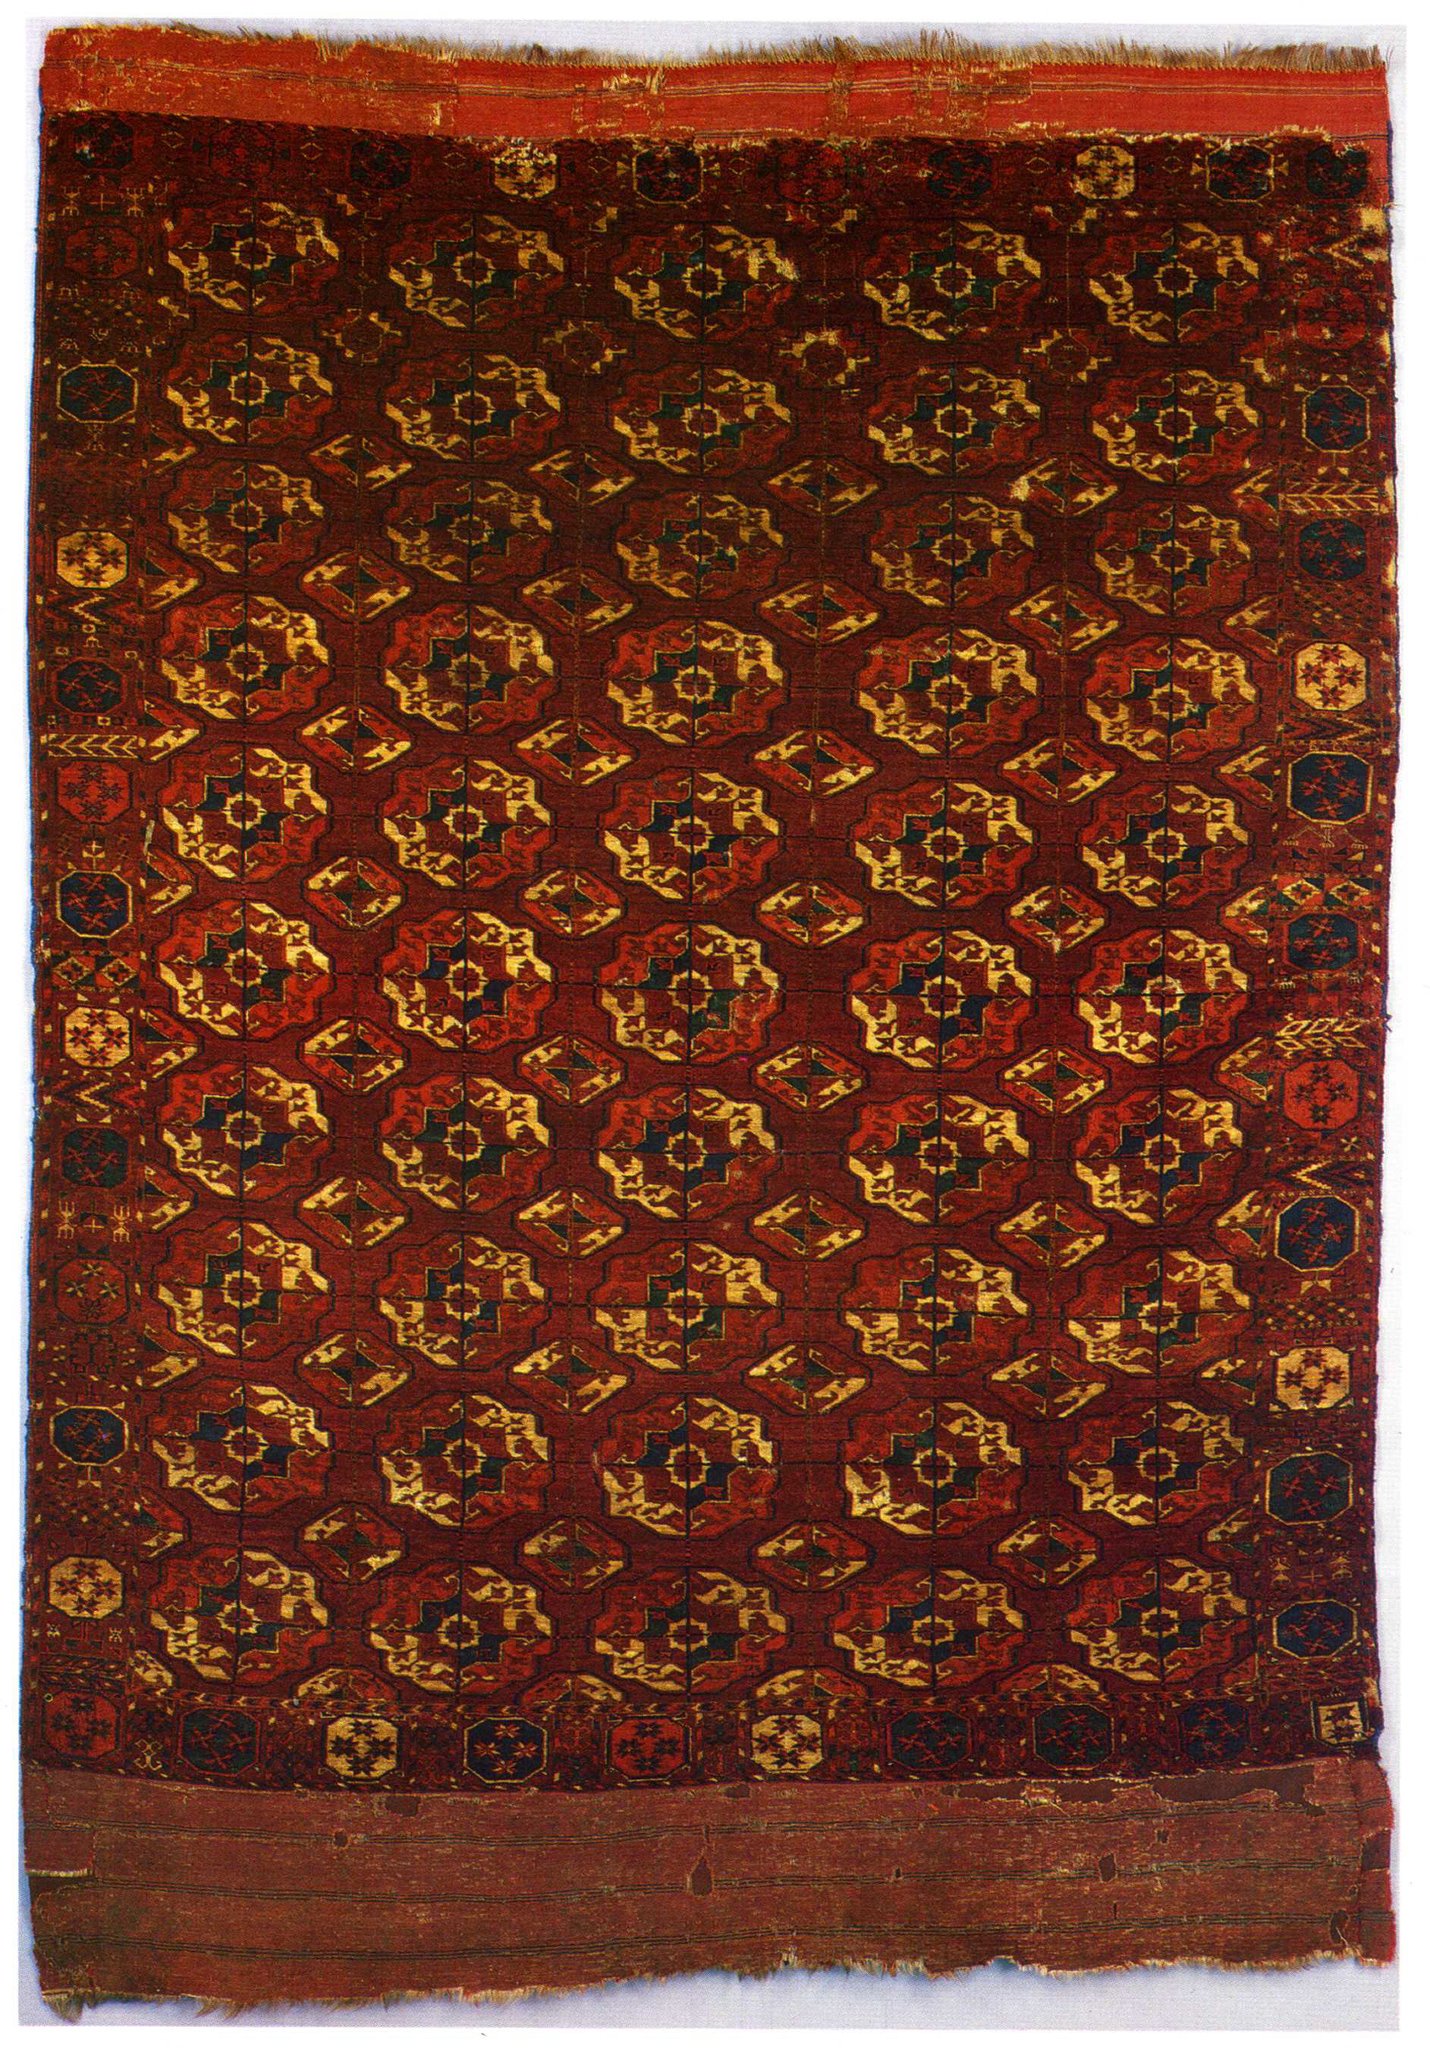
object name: carpet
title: Tekke Main Carpet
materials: wool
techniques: asymmetrically knotted pile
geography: turkmenistan